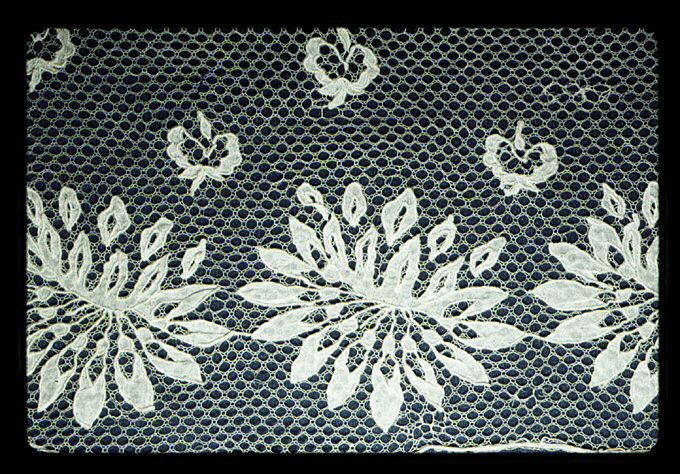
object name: fragment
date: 1801-1900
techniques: lace